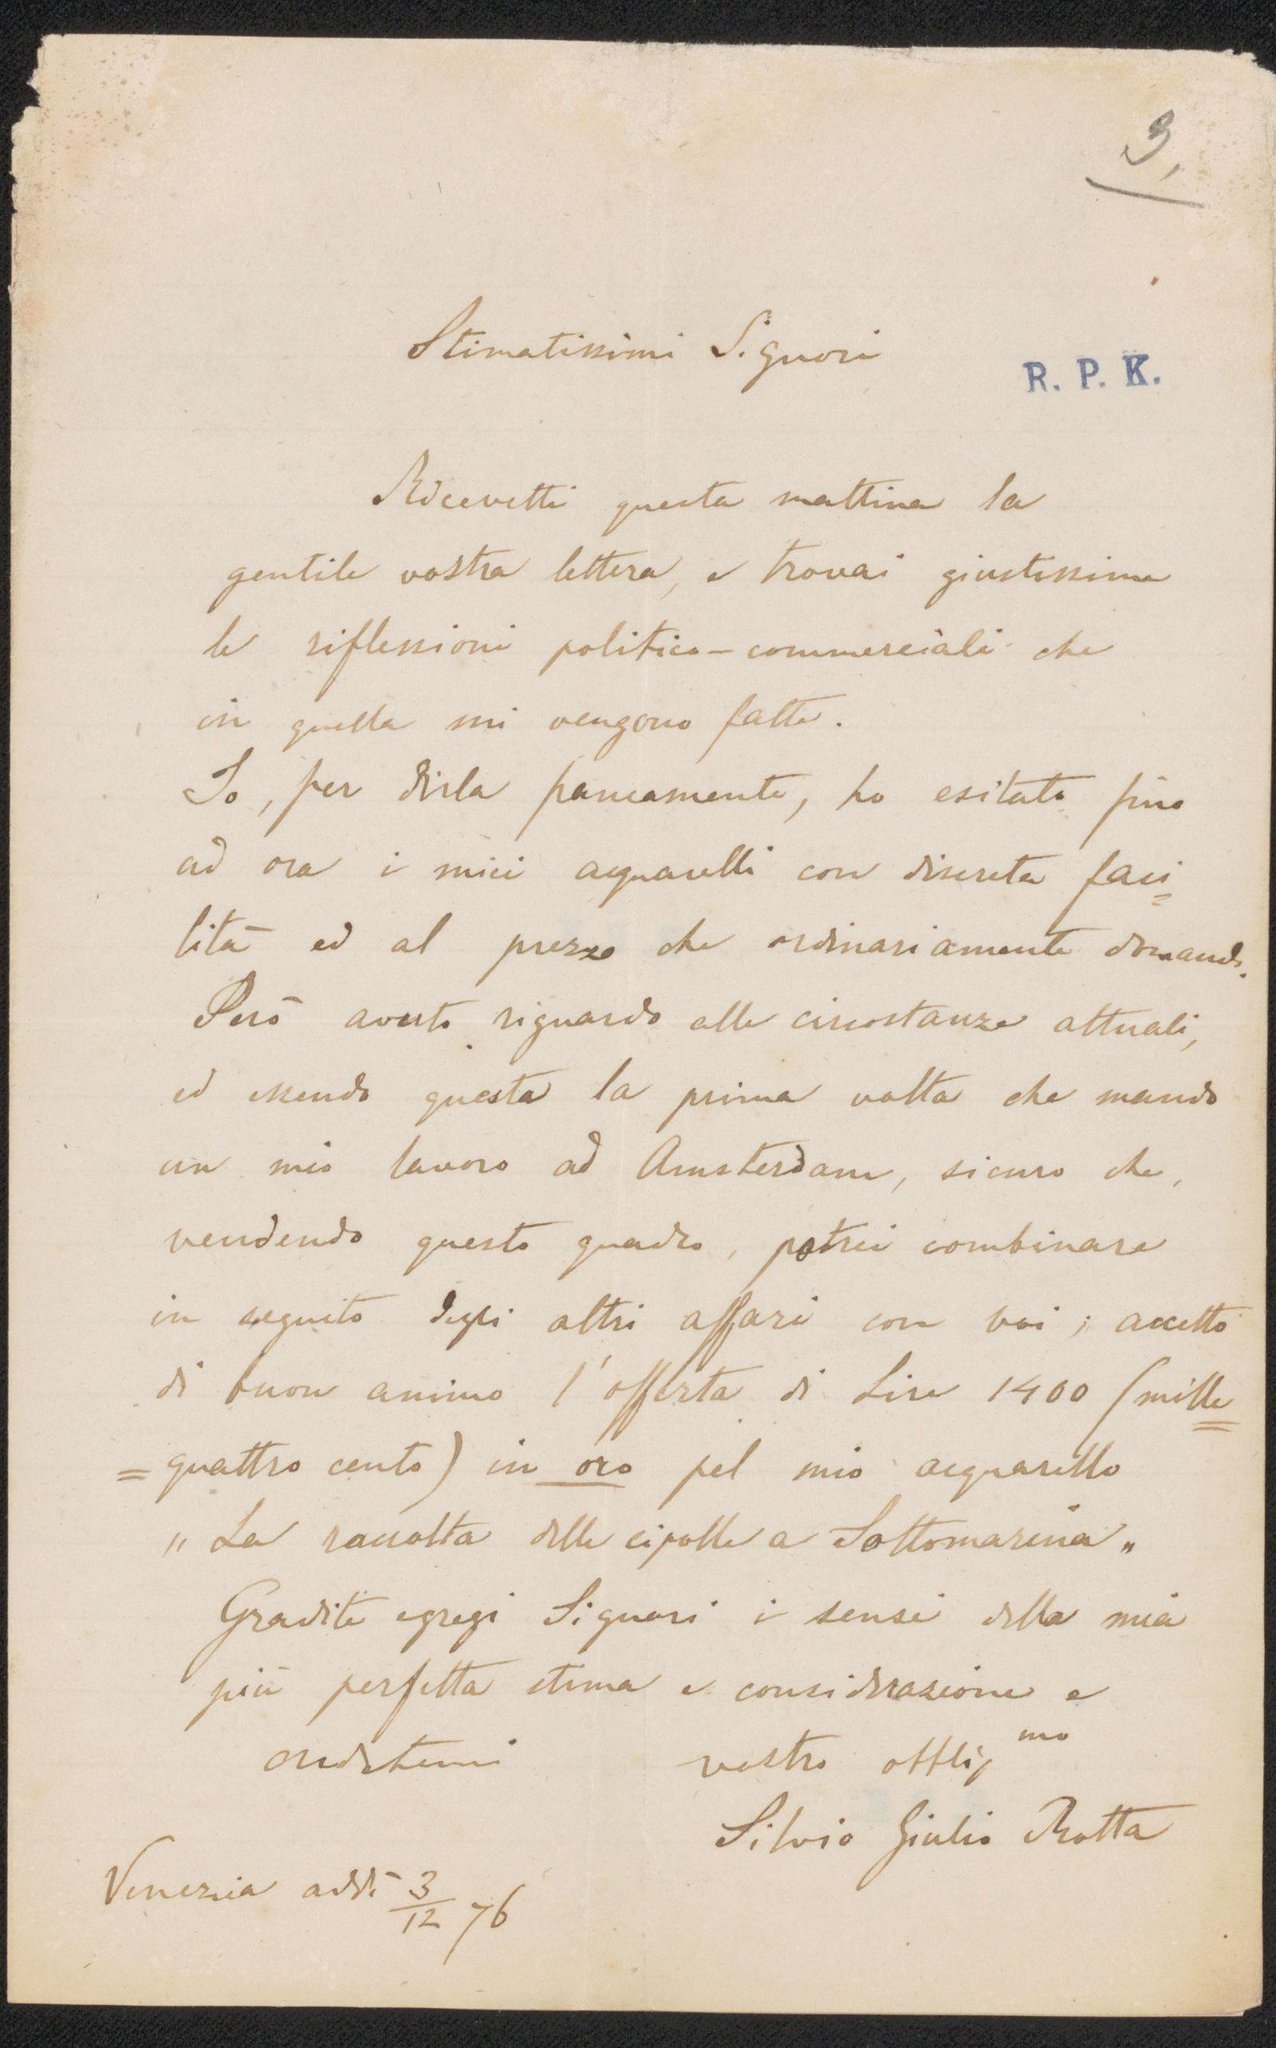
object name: letter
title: Brief aan Frans Buffa en Zonen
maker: silvio giulio rotta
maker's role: painter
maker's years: 1853-1913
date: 1876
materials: ink, paper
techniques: pen, writing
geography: venice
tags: publisher, drawing, money, amsterdam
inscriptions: collector's mark: Lugt 2233